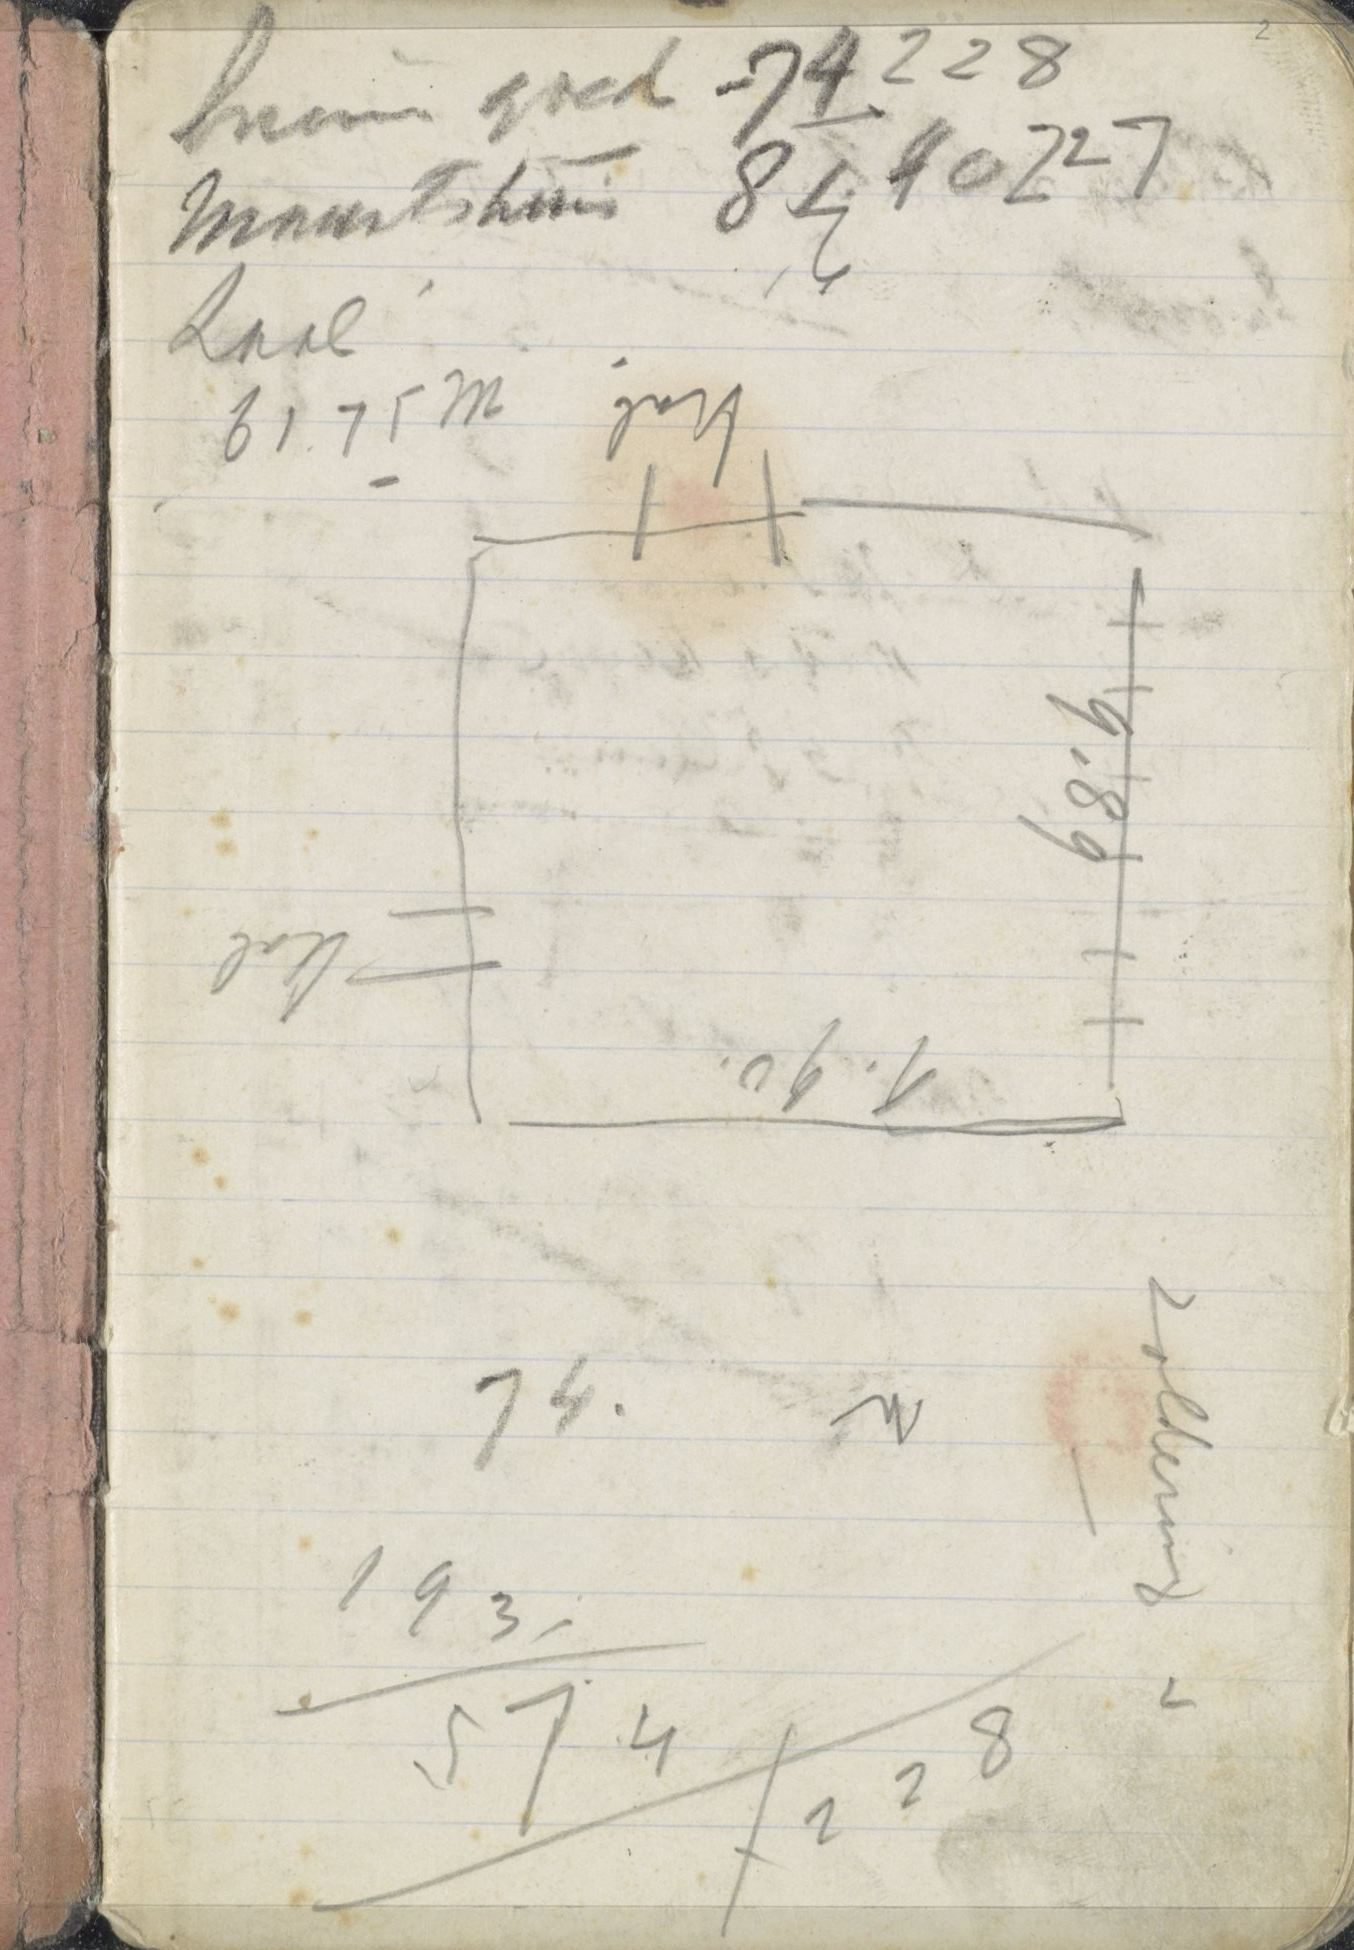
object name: sketchbook leaf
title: Annotaties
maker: george hendrik breitner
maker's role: draughtsman, painter, print maker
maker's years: 1857-1923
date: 1896-1897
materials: chalk, pencil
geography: amsterdam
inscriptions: size, annotation: ‘[...]’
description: Pagina 2 uit een schetsboek met 39 bladen.